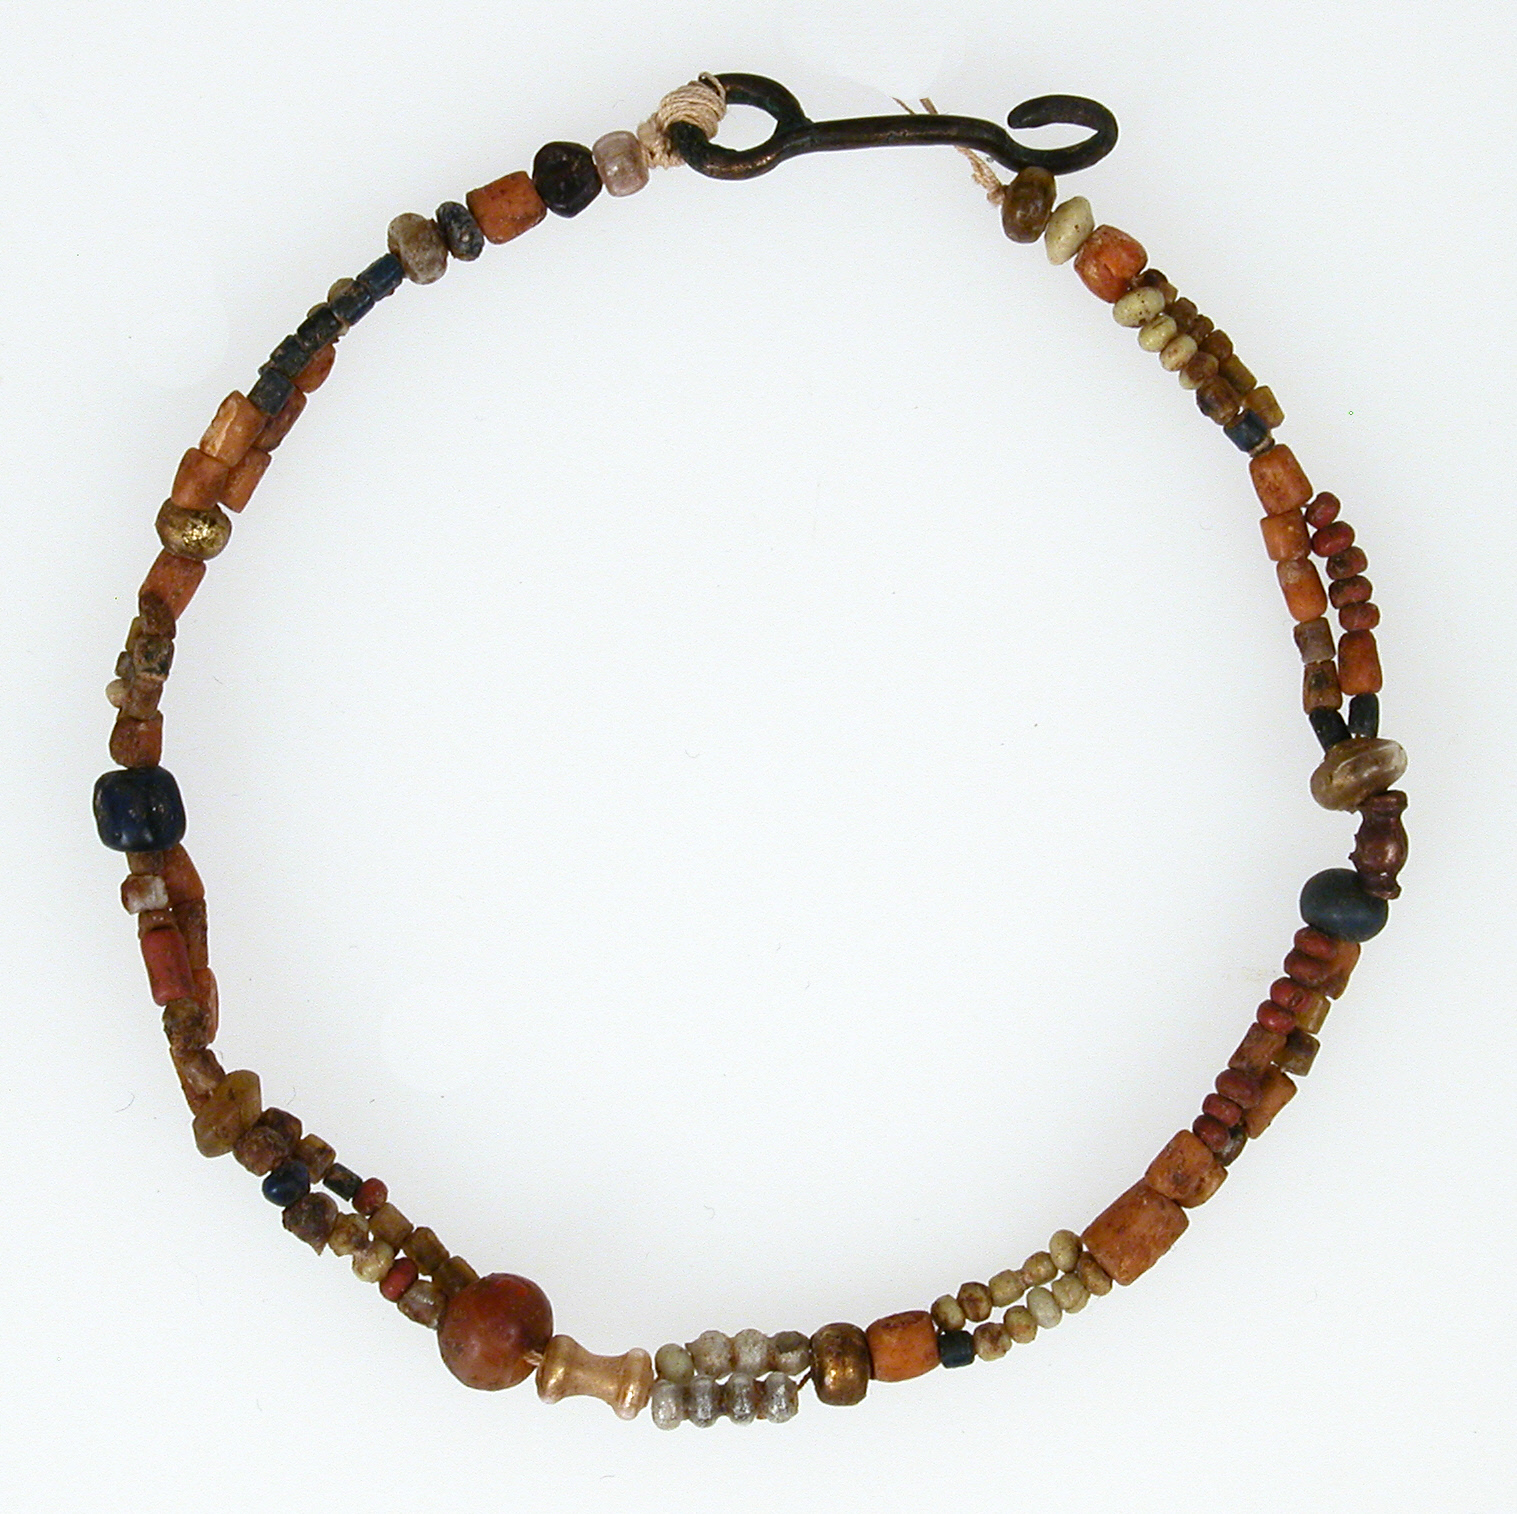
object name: bead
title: Double String of Beads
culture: coptic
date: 301-700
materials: copper alloy, glass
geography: egypt